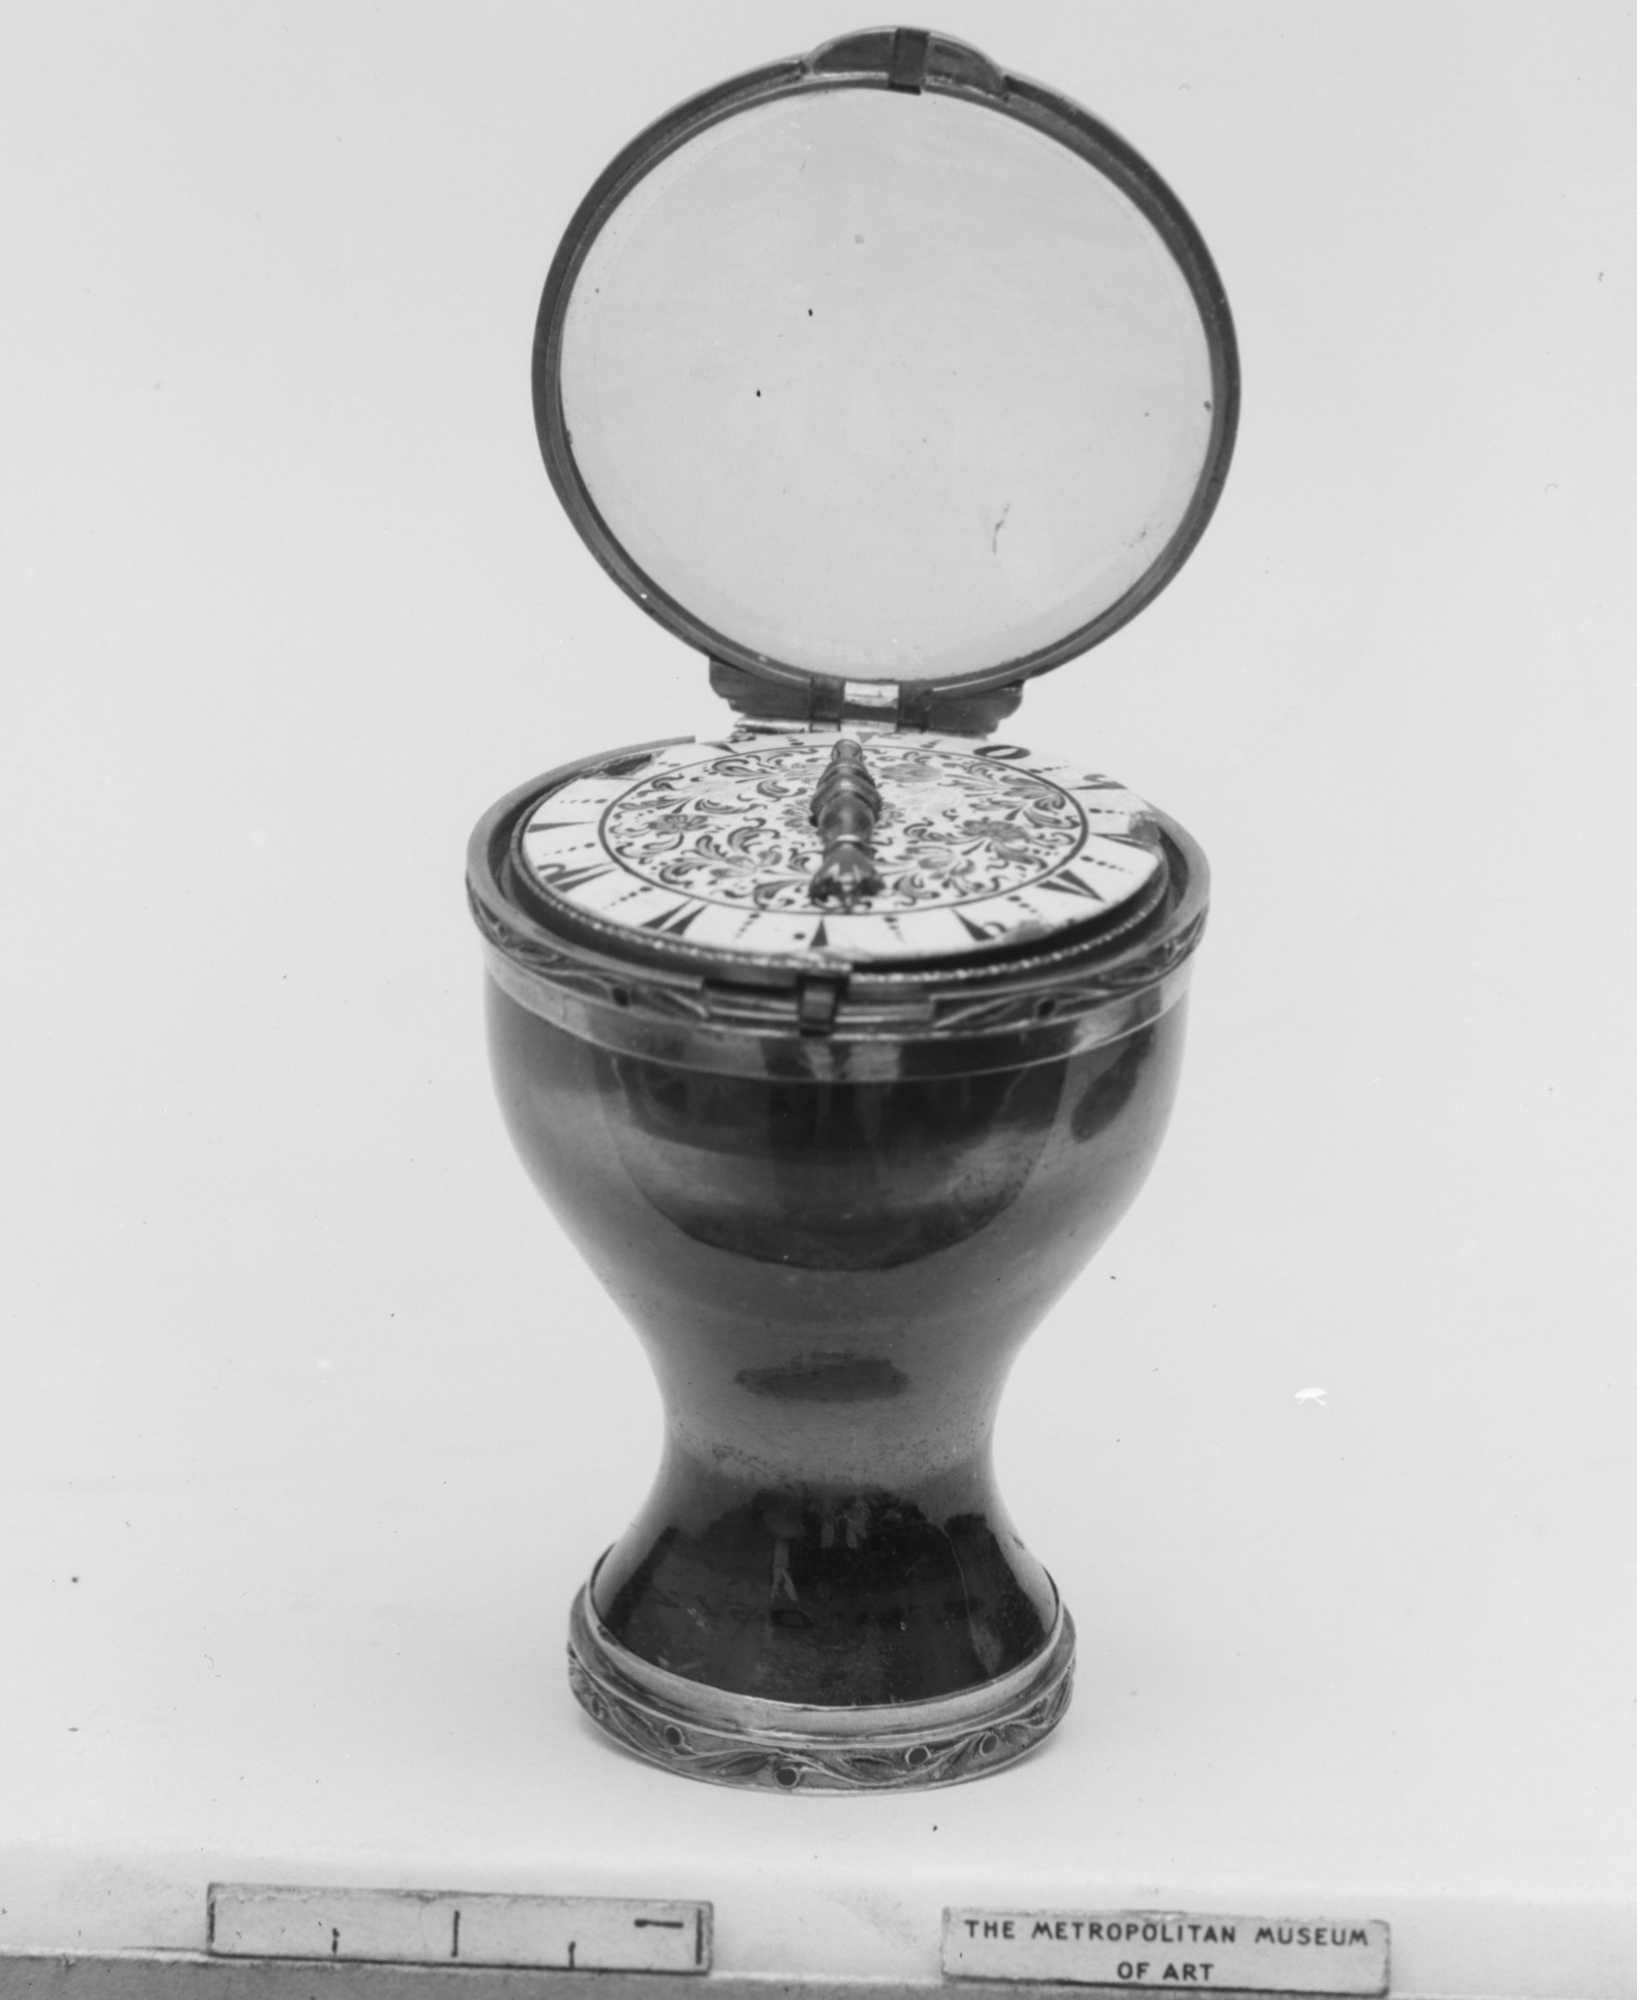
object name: watch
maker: jean hubert (l'âiné)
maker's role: maker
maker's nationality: french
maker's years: 1663-1695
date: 1645-1670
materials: crystal, enamel, gold